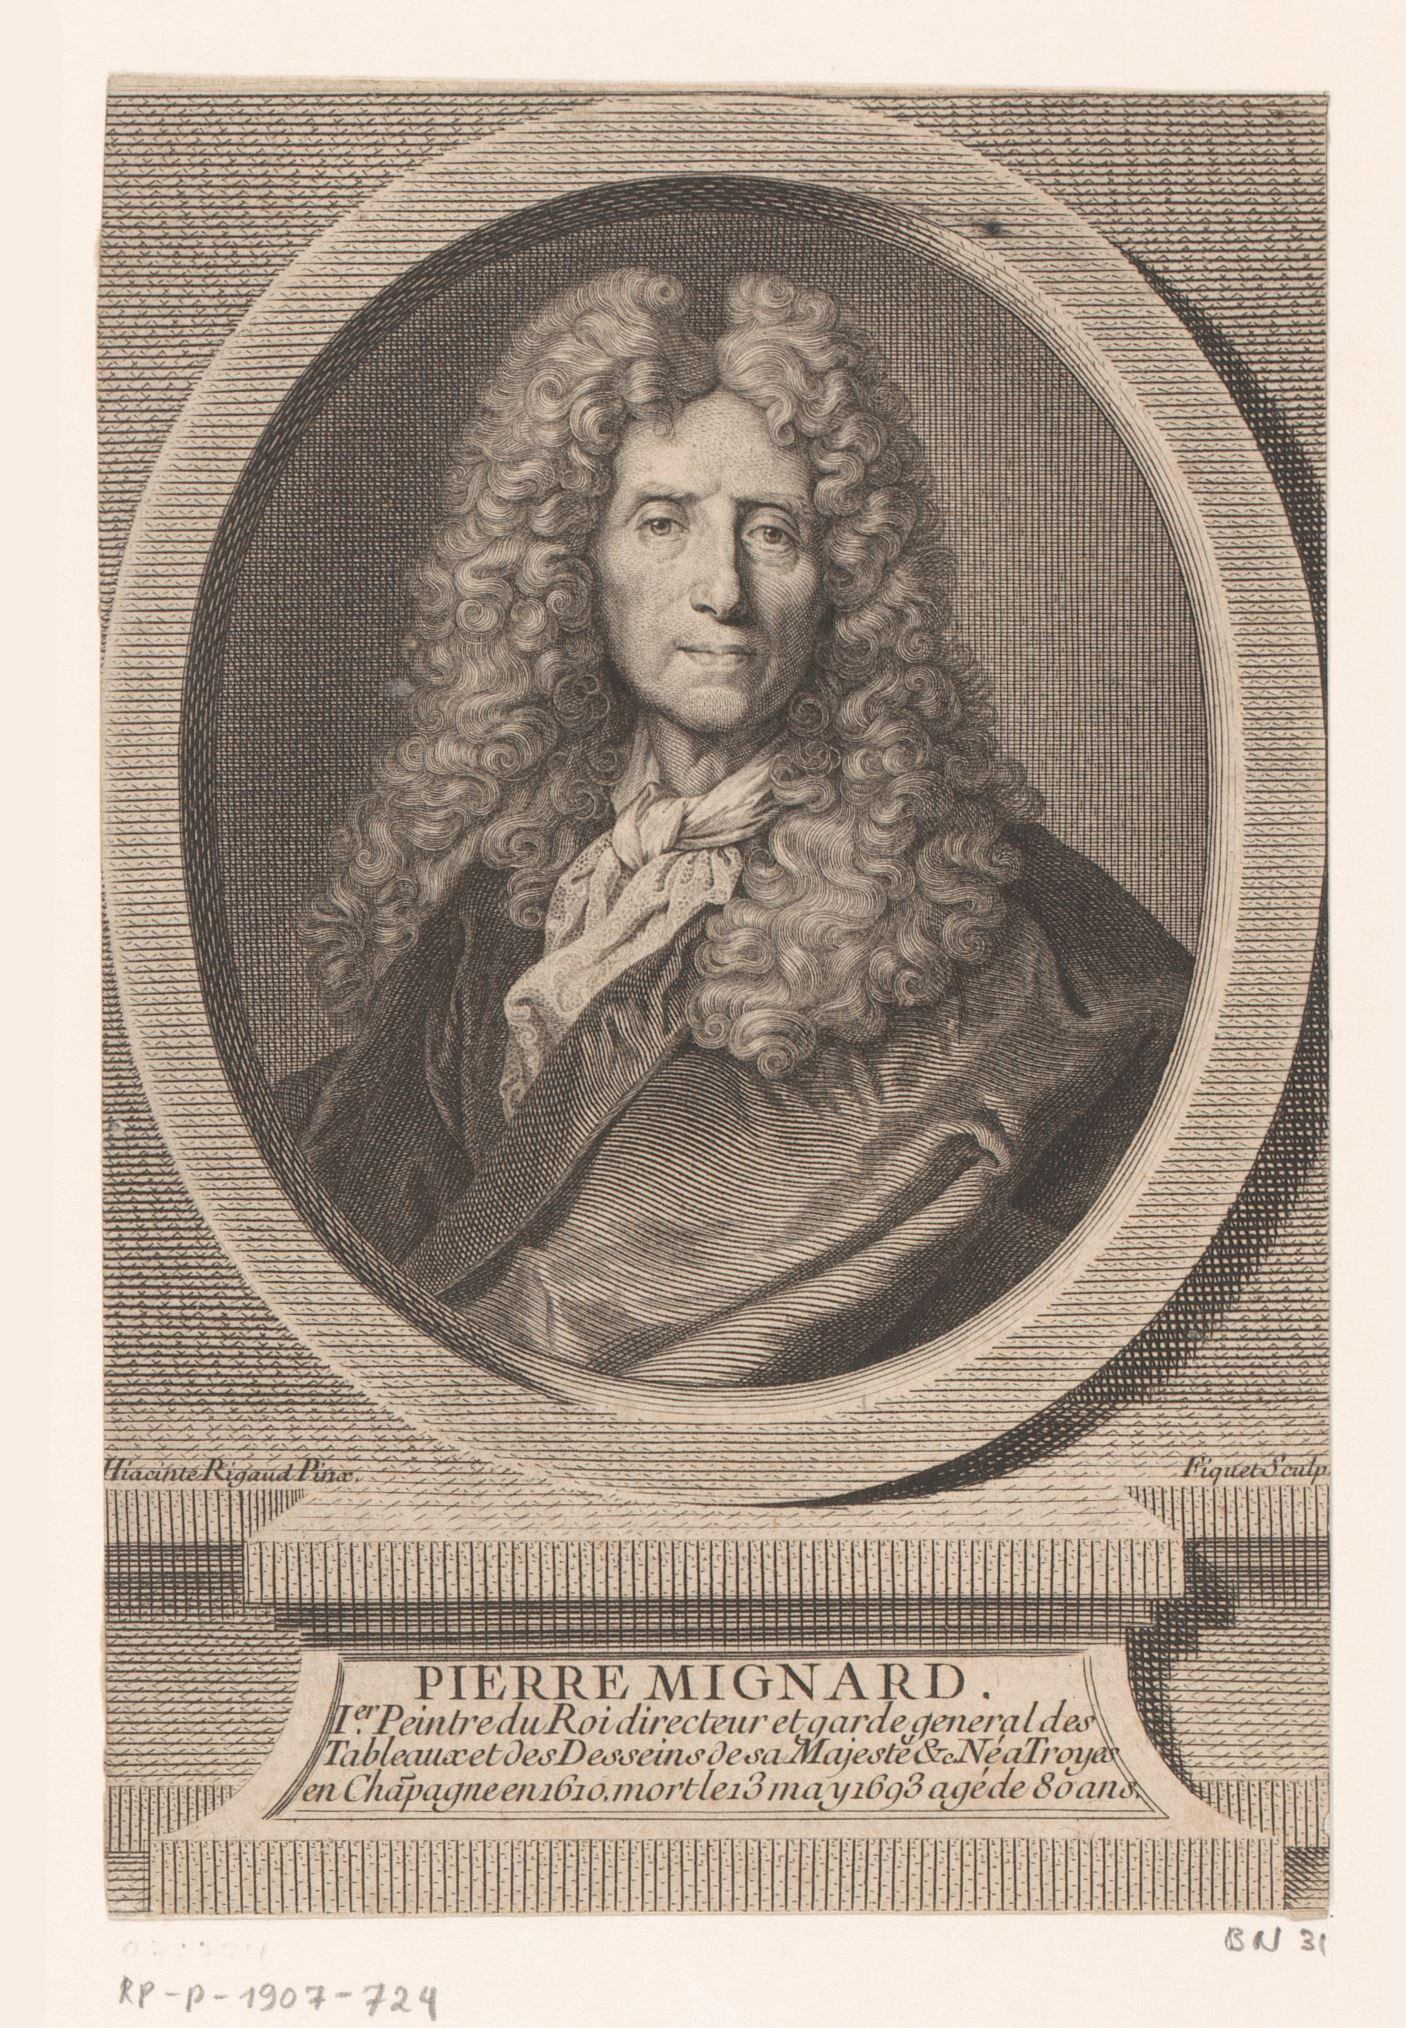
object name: print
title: Pierre Mignard.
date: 1755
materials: paper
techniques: engraving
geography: france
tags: pierre mignard, ornament ~ medallion, historical persons, portrait, self-portrait of painter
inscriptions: collector's mark: Lugt 2228